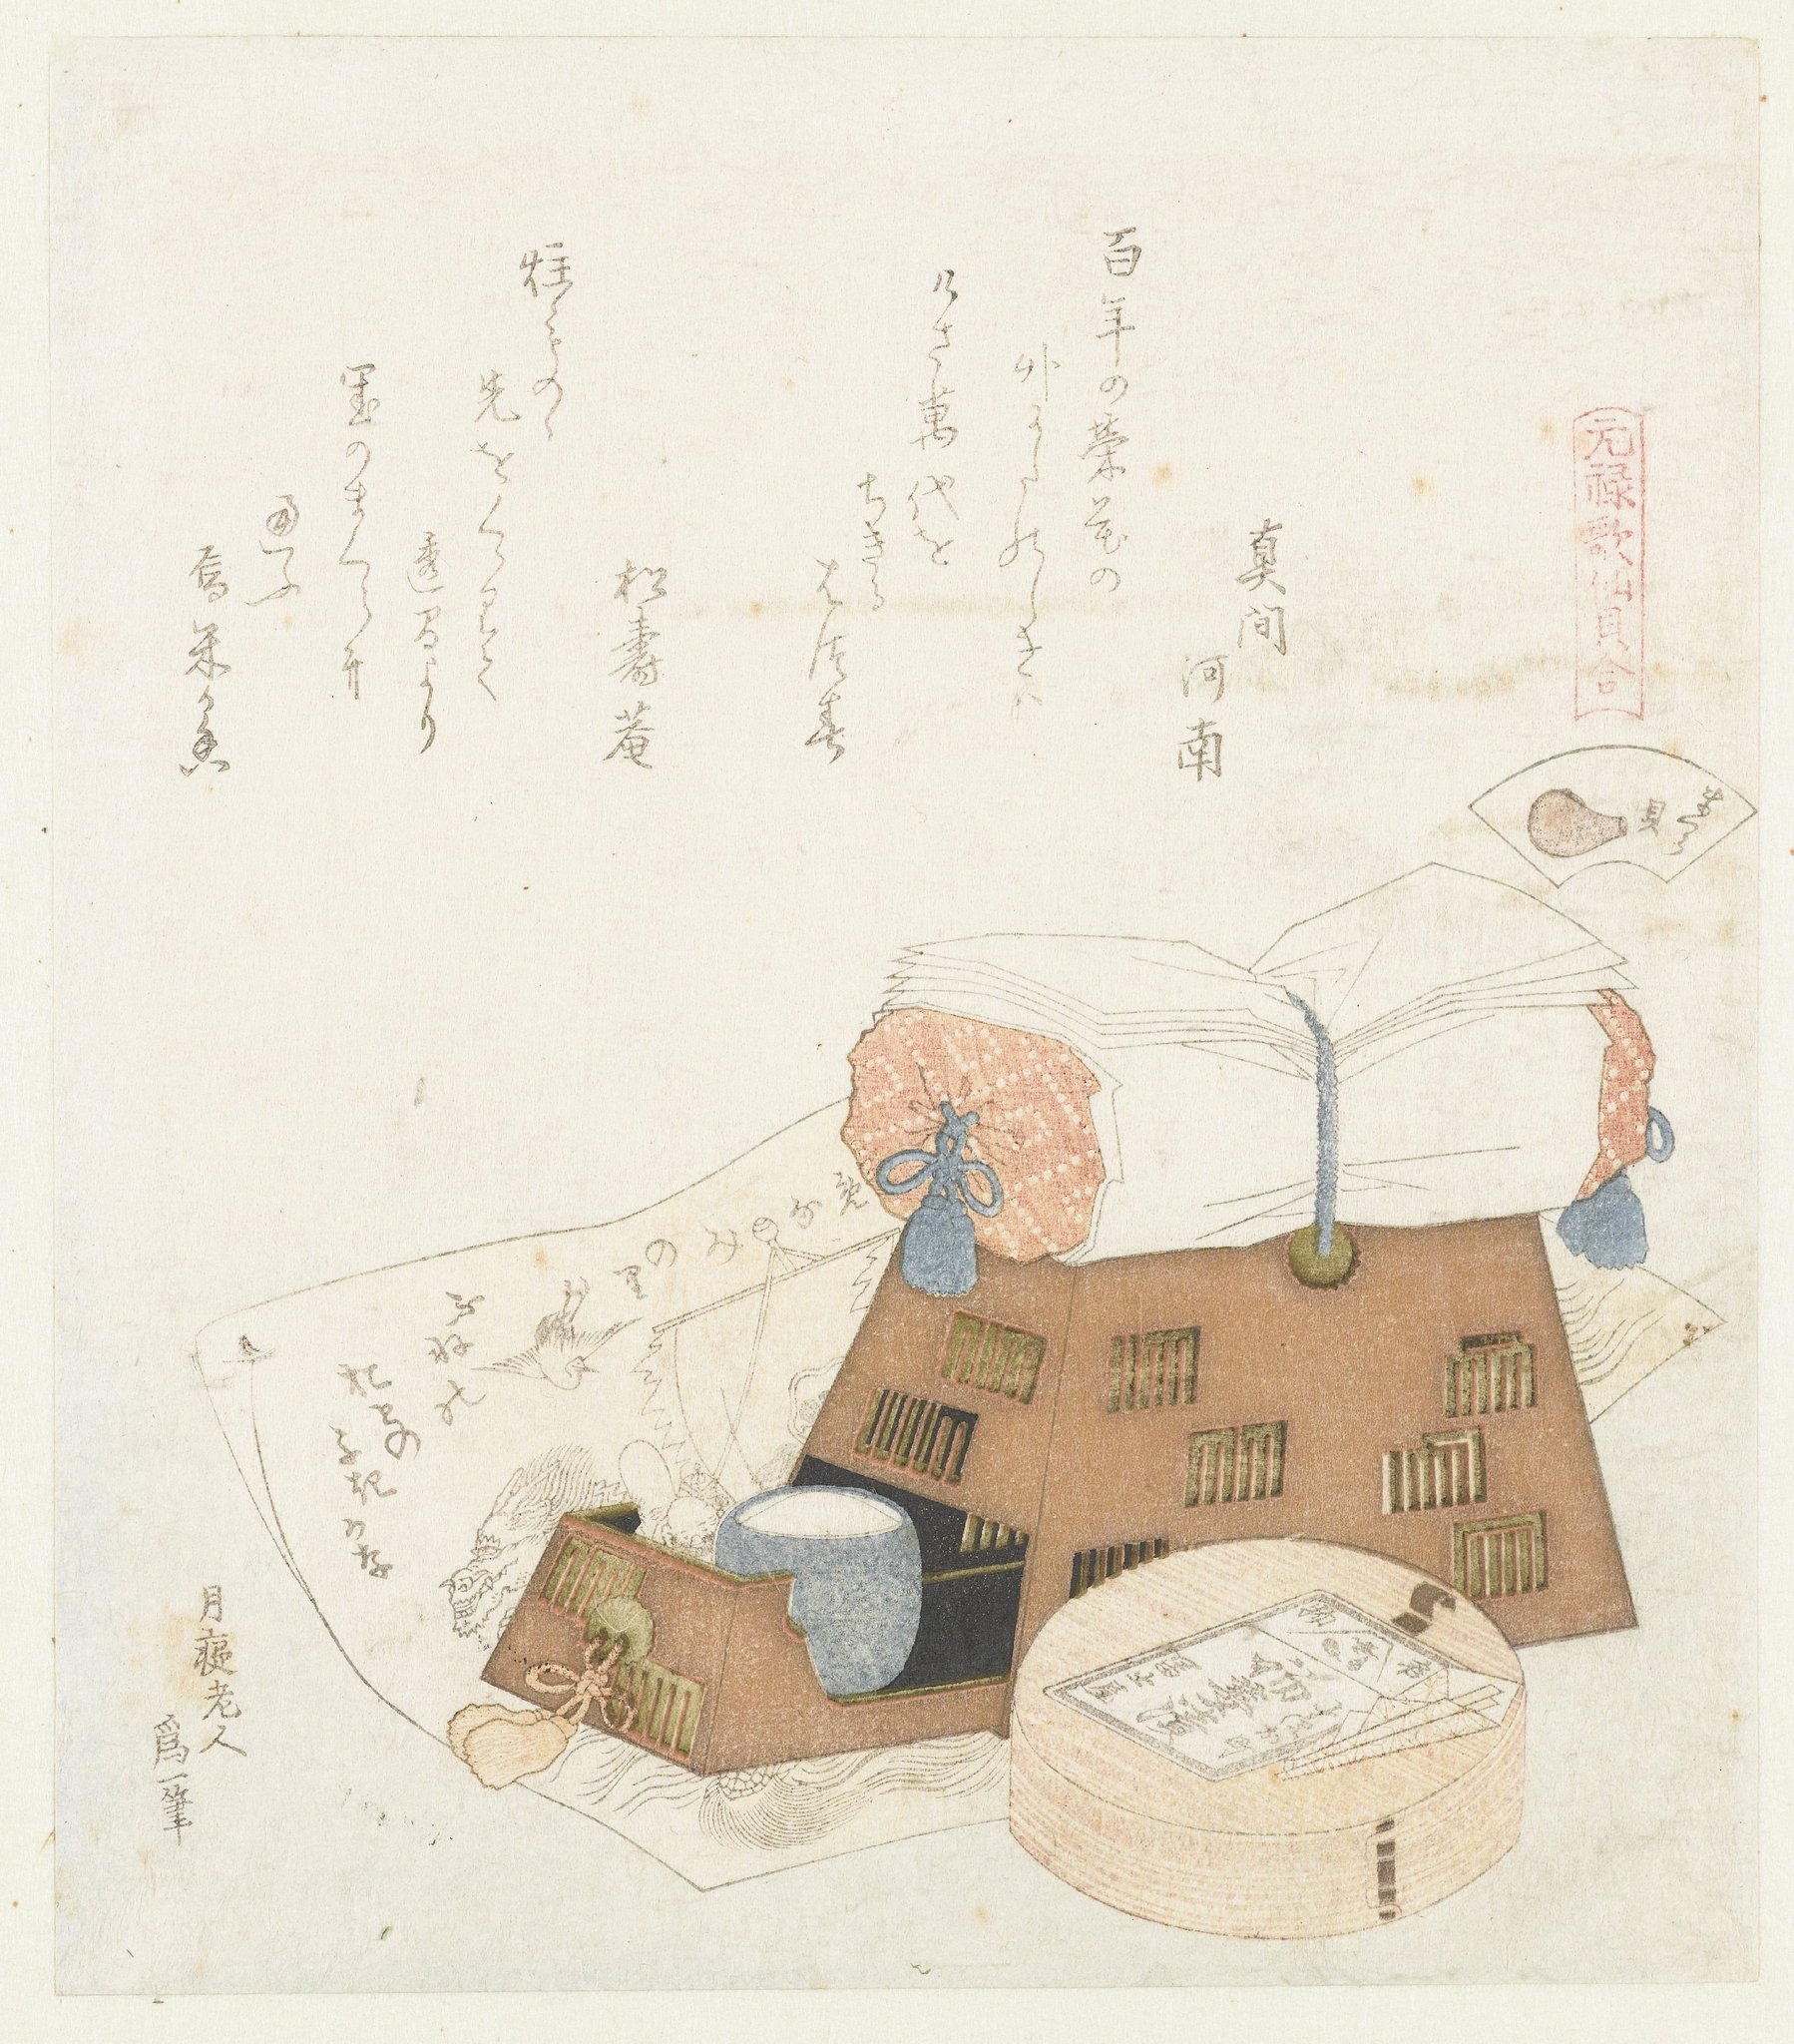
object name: surimono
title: Makuragai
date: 1821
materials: paper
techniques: blind stamped, woodcut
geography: japan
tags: pillow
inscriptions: collector's mark, verso, stamped: Lugt 2228, collector's mark, passe-partout, bottom left, printed: JABdH with a rooster.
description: Een surimono is een luxe uitgevoerde prent waarop beeld met één of meerdere gedichten gecombineerd is. Bij het drukken van een surimono werd vaak gebruik gemaakt van dikker papier, blinddruk en metaal pigmenten, zoals koper- en zilverpoeder. De prenten werden vaak in opdracht van dichters gemaakt en als exclusief geschenk aan vrienden en relaties gegeven.